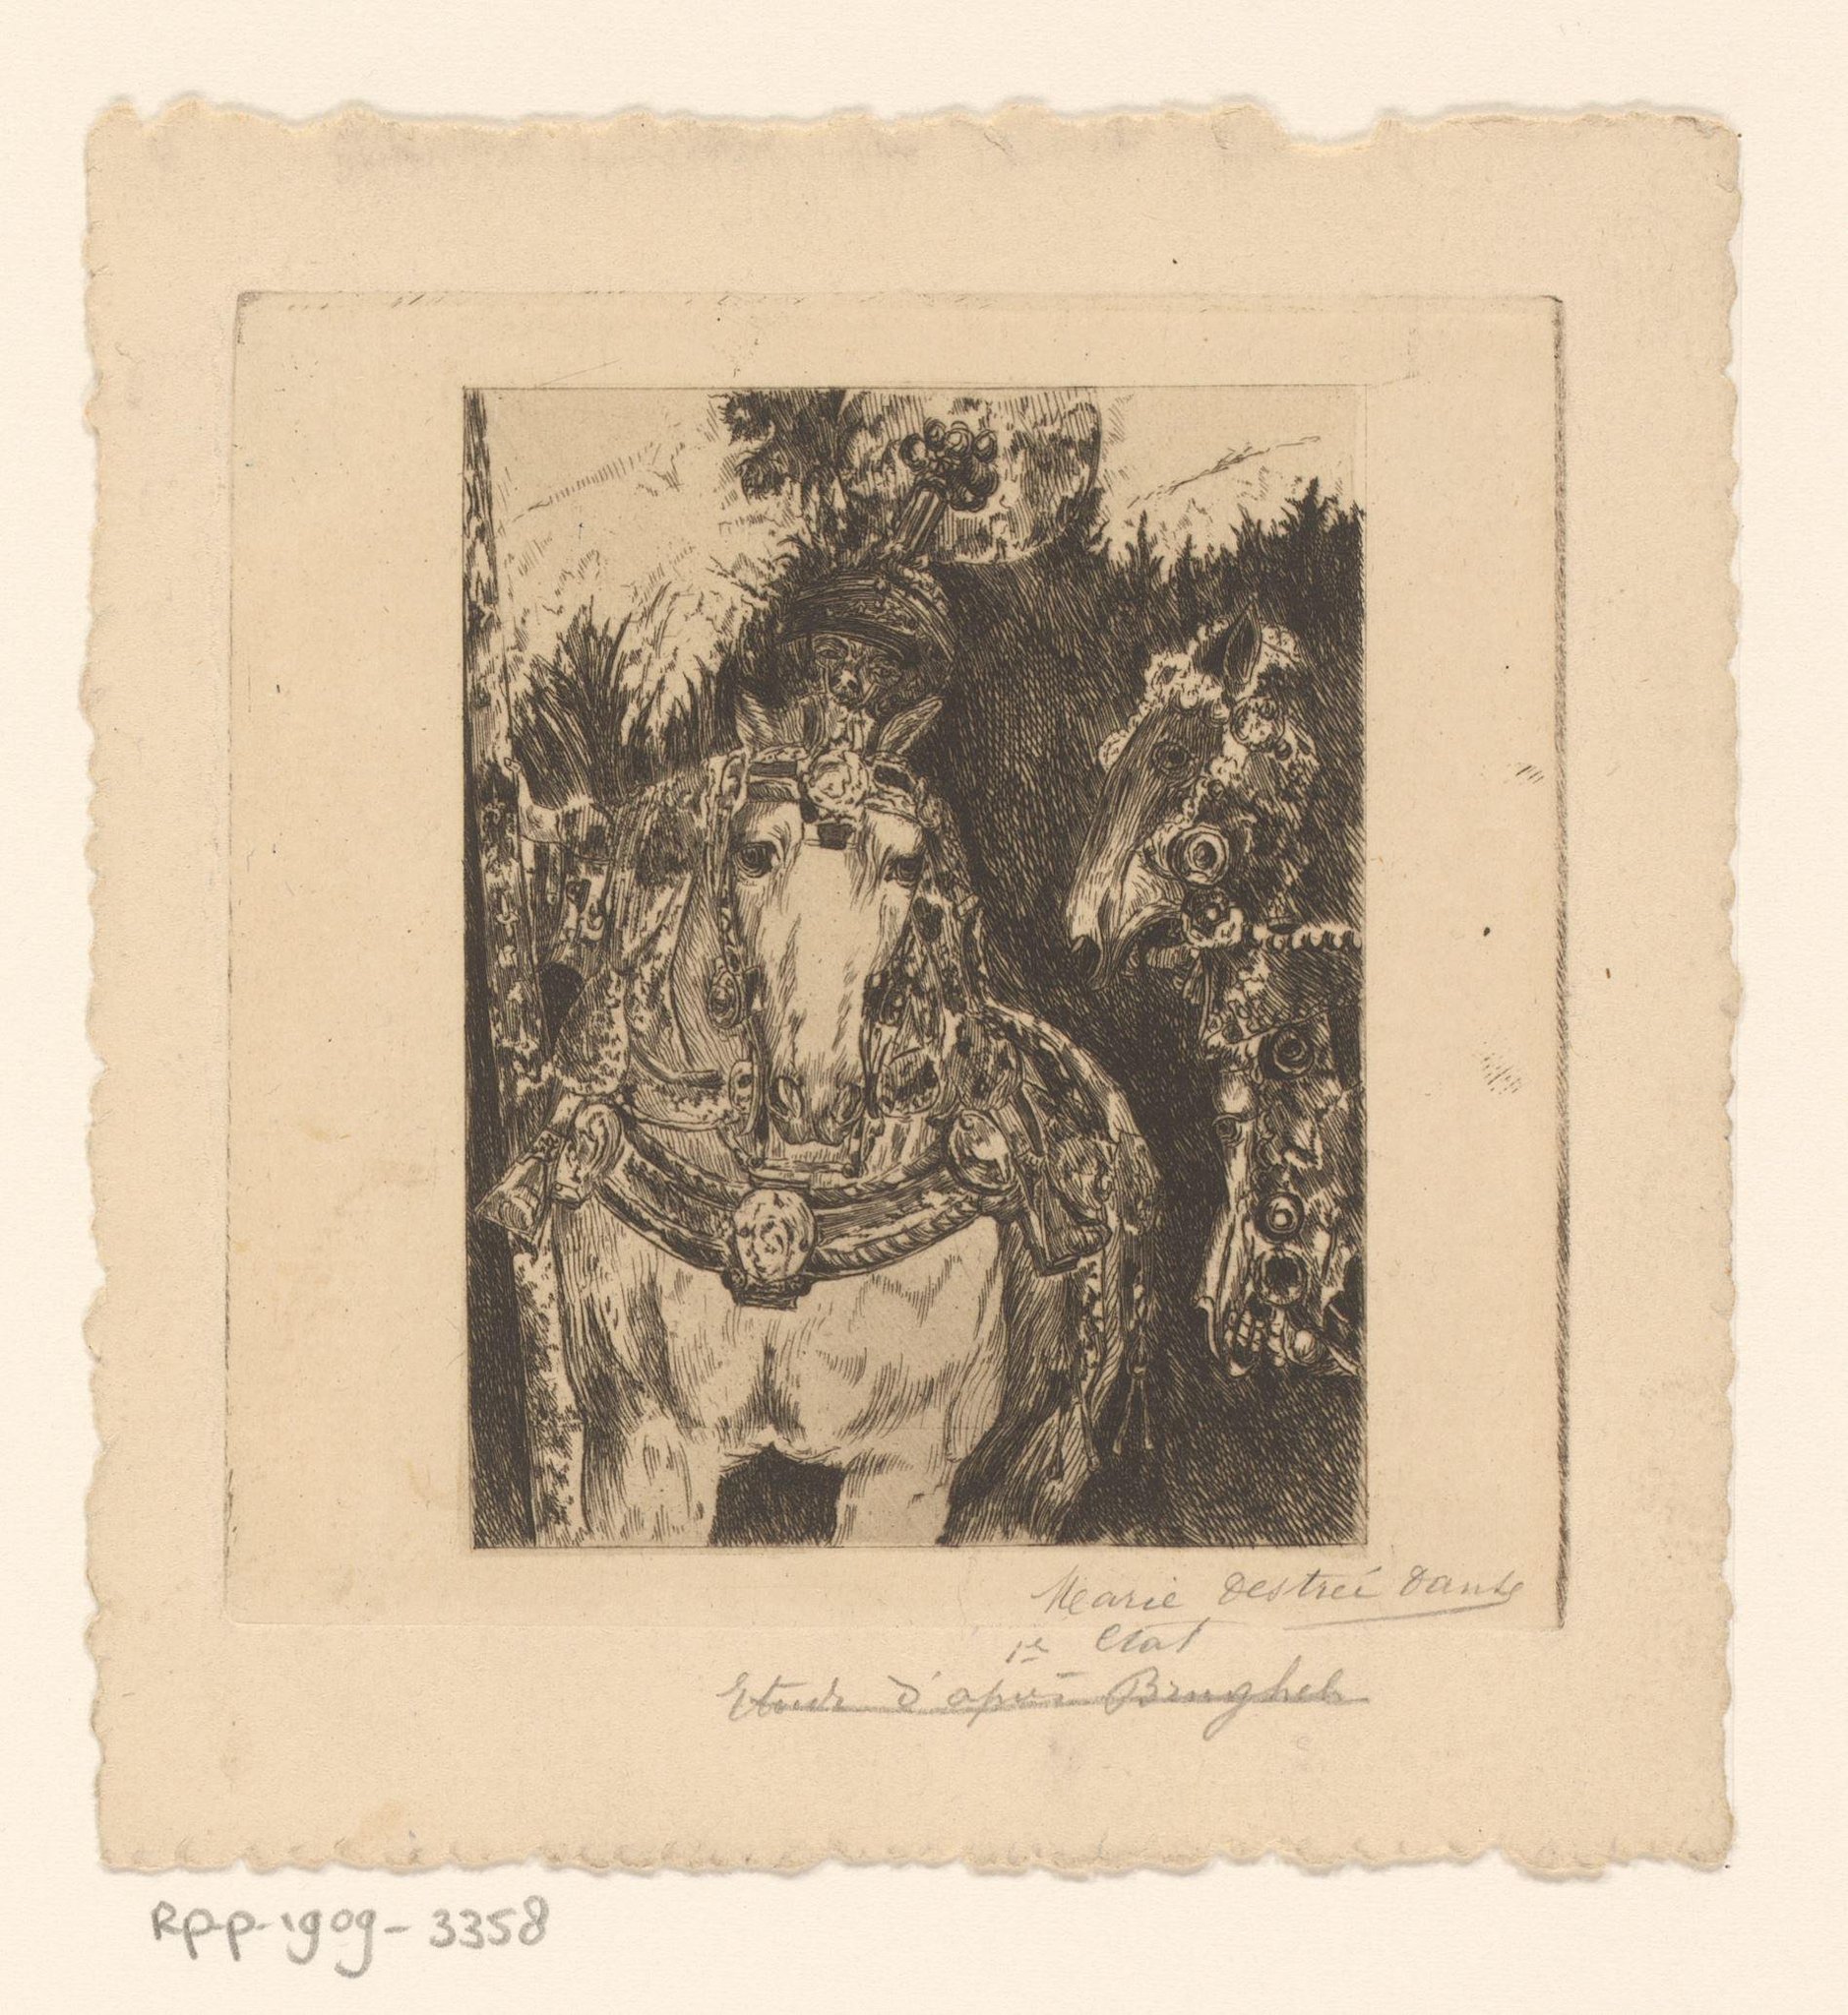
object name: print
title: Ruiter te paard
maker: marie danse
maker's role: print maker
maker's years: 1867-1942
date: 1889-1909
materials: paper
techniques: etching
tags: riding a horse, ass, or mule; rider, horseman, st. george and the dragon: dressed in armour and mounted on a (white) horse he brandishes his sword (his lance lies already broken on the ground); the princess nearby may be shown praying or fleeing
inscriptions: inscription: ‘1e etat’, collector's mark: Lugt 2228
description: Prent naar een detail uit het fresco van Pisanello te Verona: St. George en de prinses.